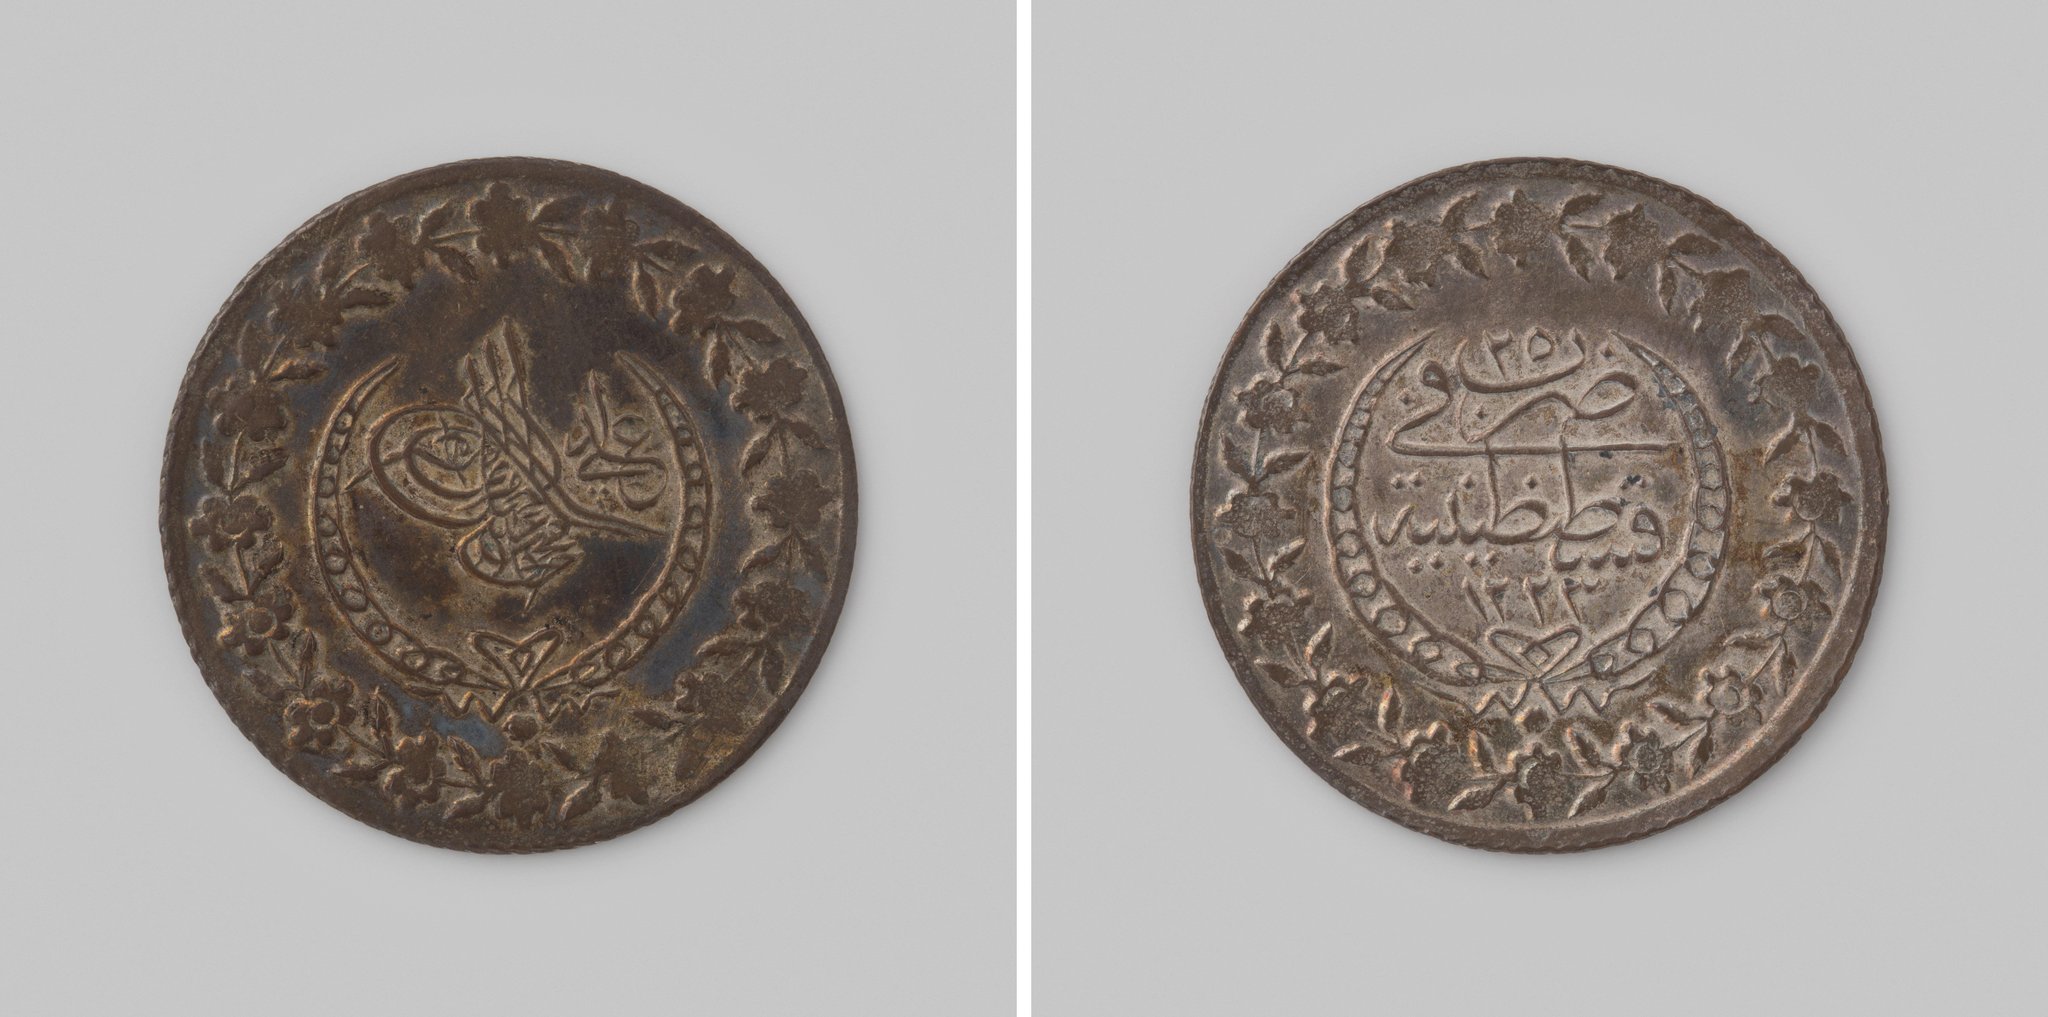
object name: coin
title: 100 para uit Turkije van sultan Mahmud II, regeringsjaar 25 [=1832]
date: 1832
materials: silver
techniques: striking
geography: constantinople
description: Koper-zilveren munt. Voorzijde: binnen bloemenrand tussen twee samengebonden halve manen, met onder de strik een zeshoek, tughra met rechts daarvan opschrift: adli. Keerzijde: binnen bloemenrand tussen twee samengebonden halve manen, met onder de strik een zeshoek, in Arabische letters drieregelig opschrift met muntplaats-aanduiding: Constantinopel. Boven in opschrift regeringsjaar: 25. Onderaan jaar van aantreden: 1223 [=1808].